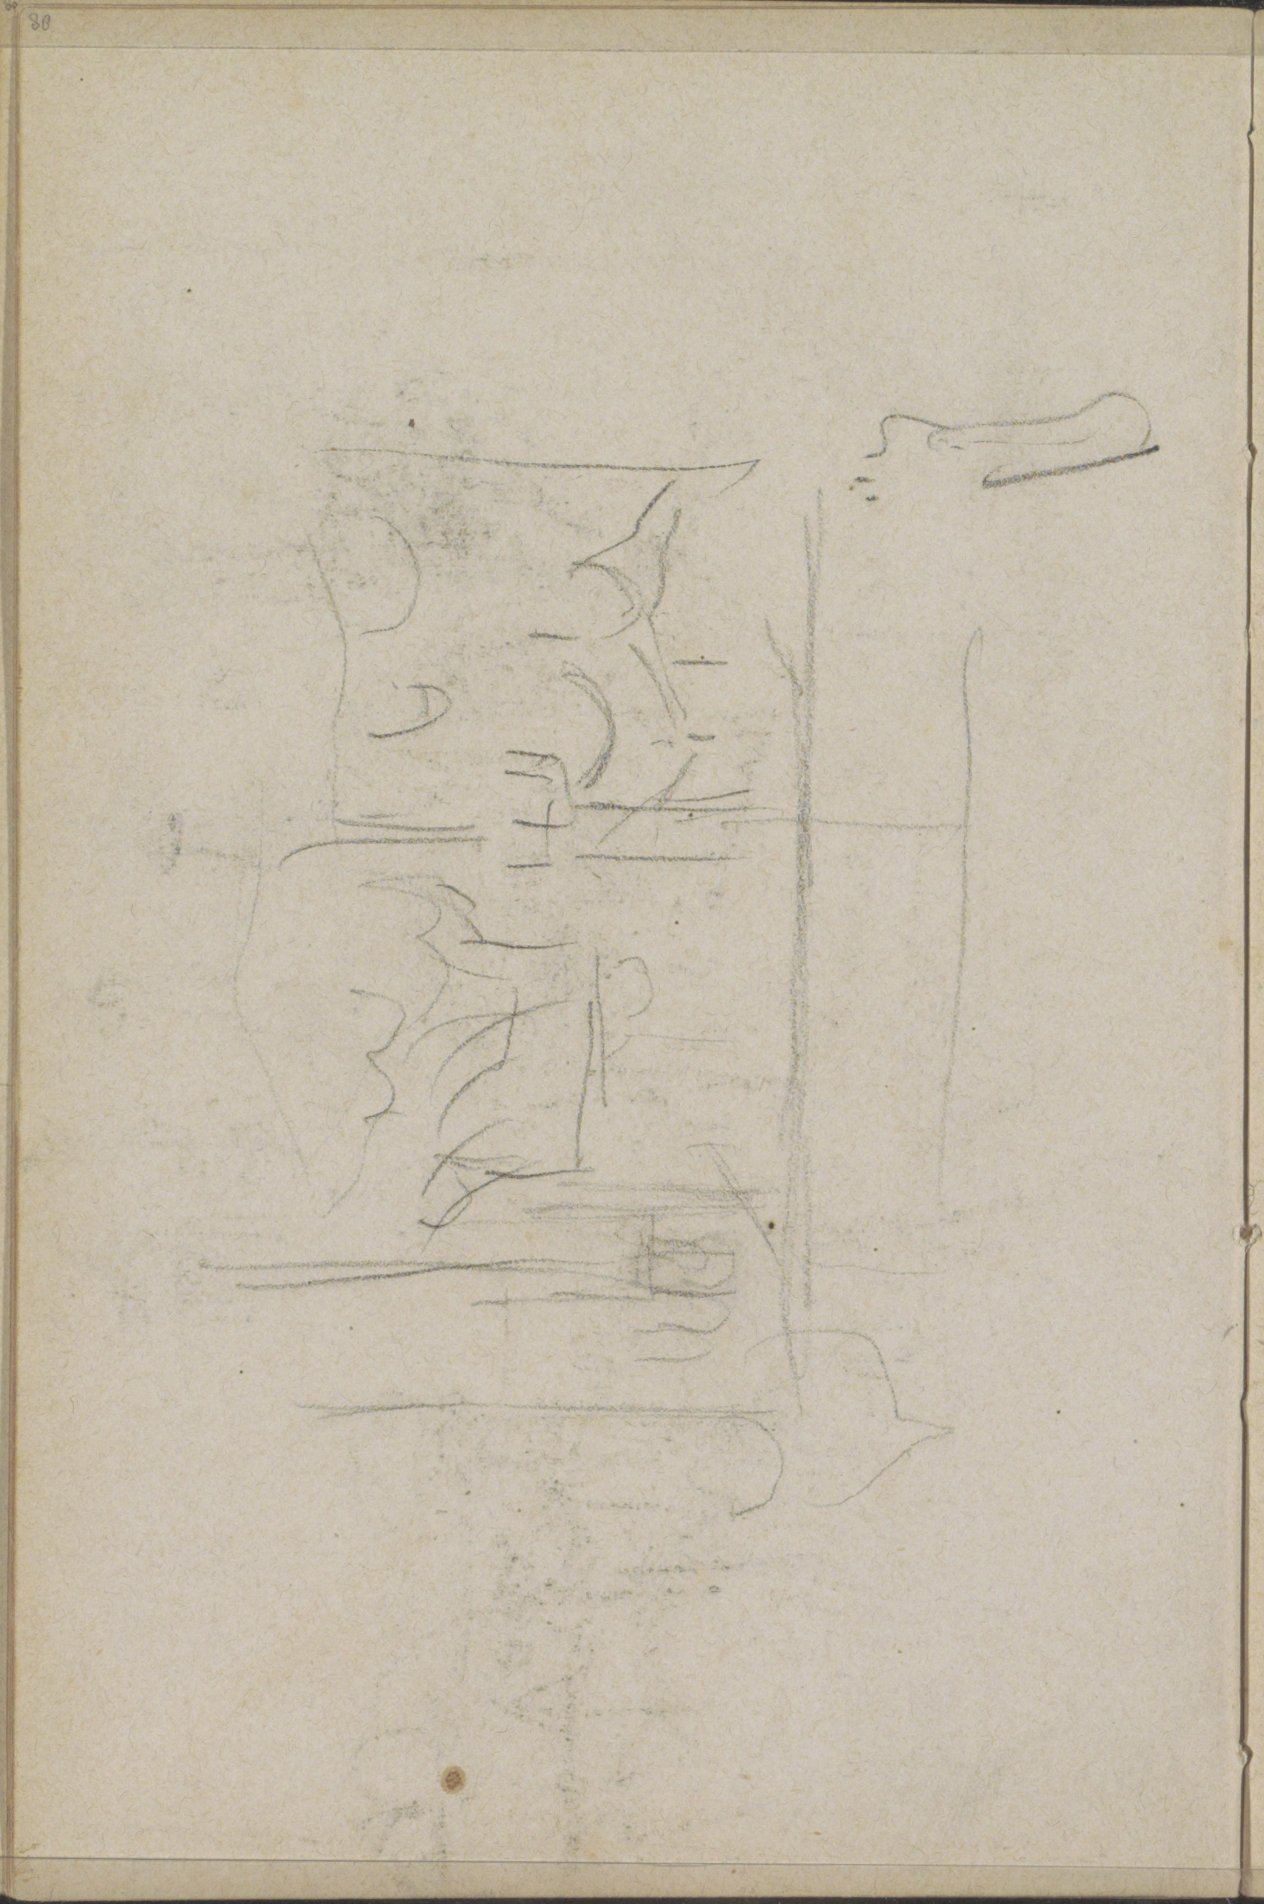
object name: sketchbook leaf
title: Architectuurstudie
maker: marius bauer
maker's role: draughtsman, print maker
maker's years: 1867-1932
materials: chalk, paper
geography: russia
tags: architecture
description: Pagina 88 uit een schetsboek met 54 bladen.